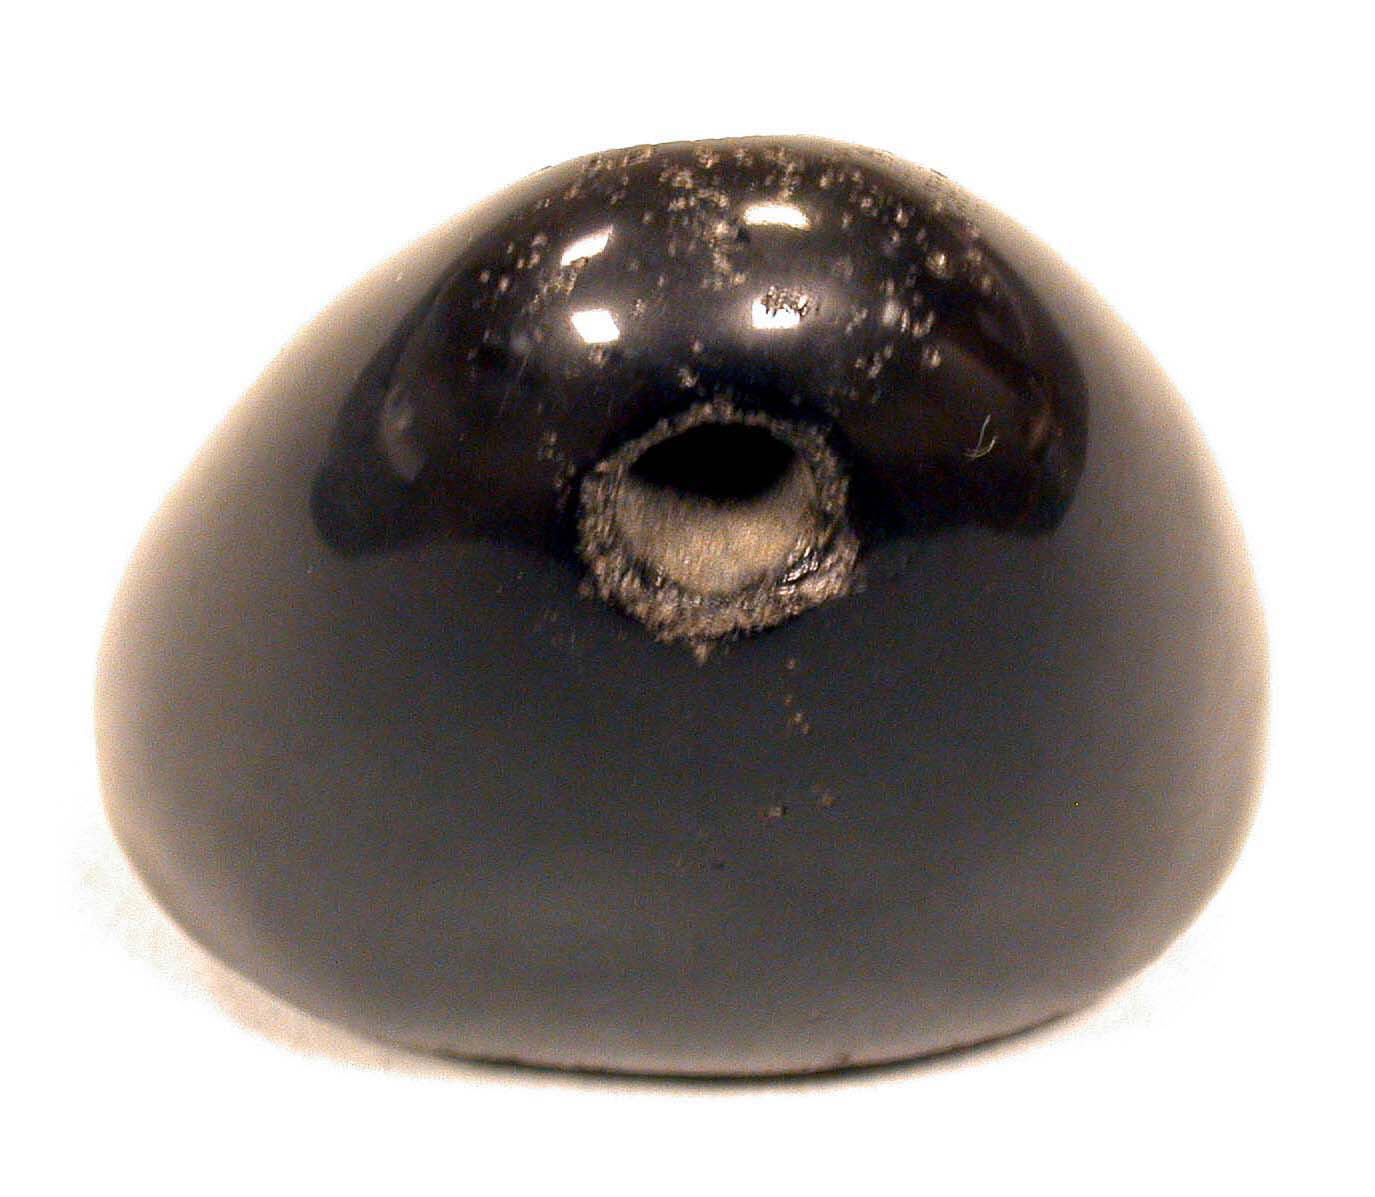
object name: pendant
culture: mexican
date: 1501-1600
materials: obsidian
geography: mexico